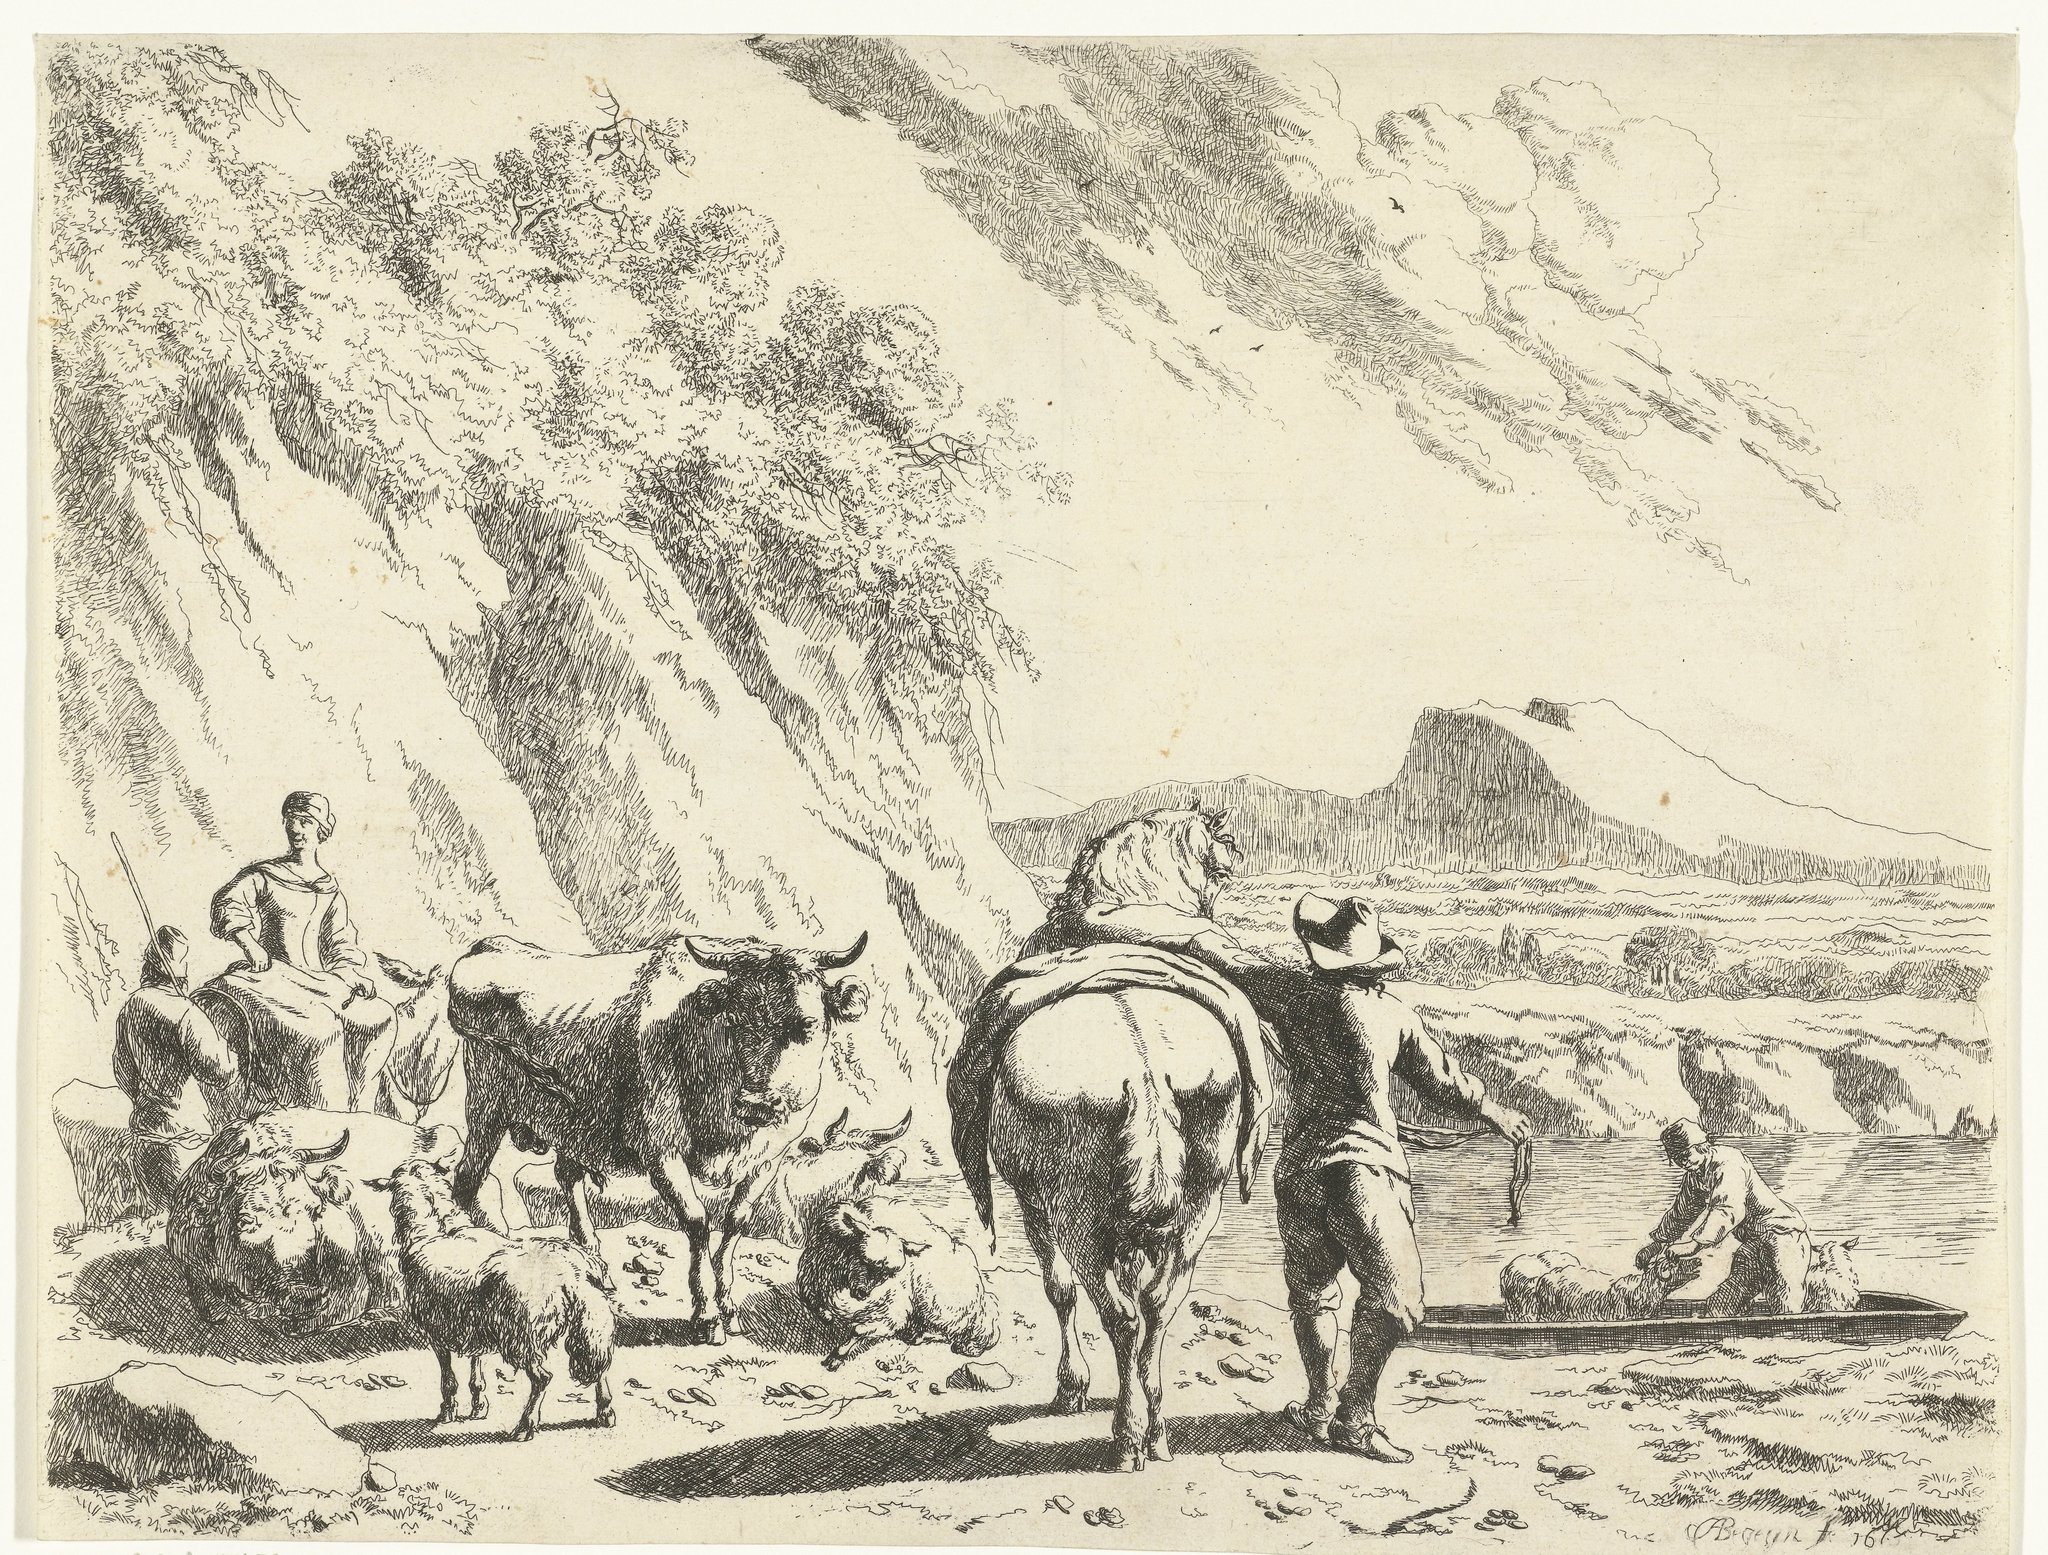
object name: print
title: Man met paard en herderin op ezel met vee in heuvelachtig landschap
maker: abraham jansz begeyn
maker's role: draughtsman, print maker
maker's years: 1637-1697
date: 1665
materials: paper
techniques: etching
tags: herding, herdsman, herdswoman, shepherd, shepherdess, cowherd, etc., herd, flock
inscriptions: collector's mark: Lugt 2228